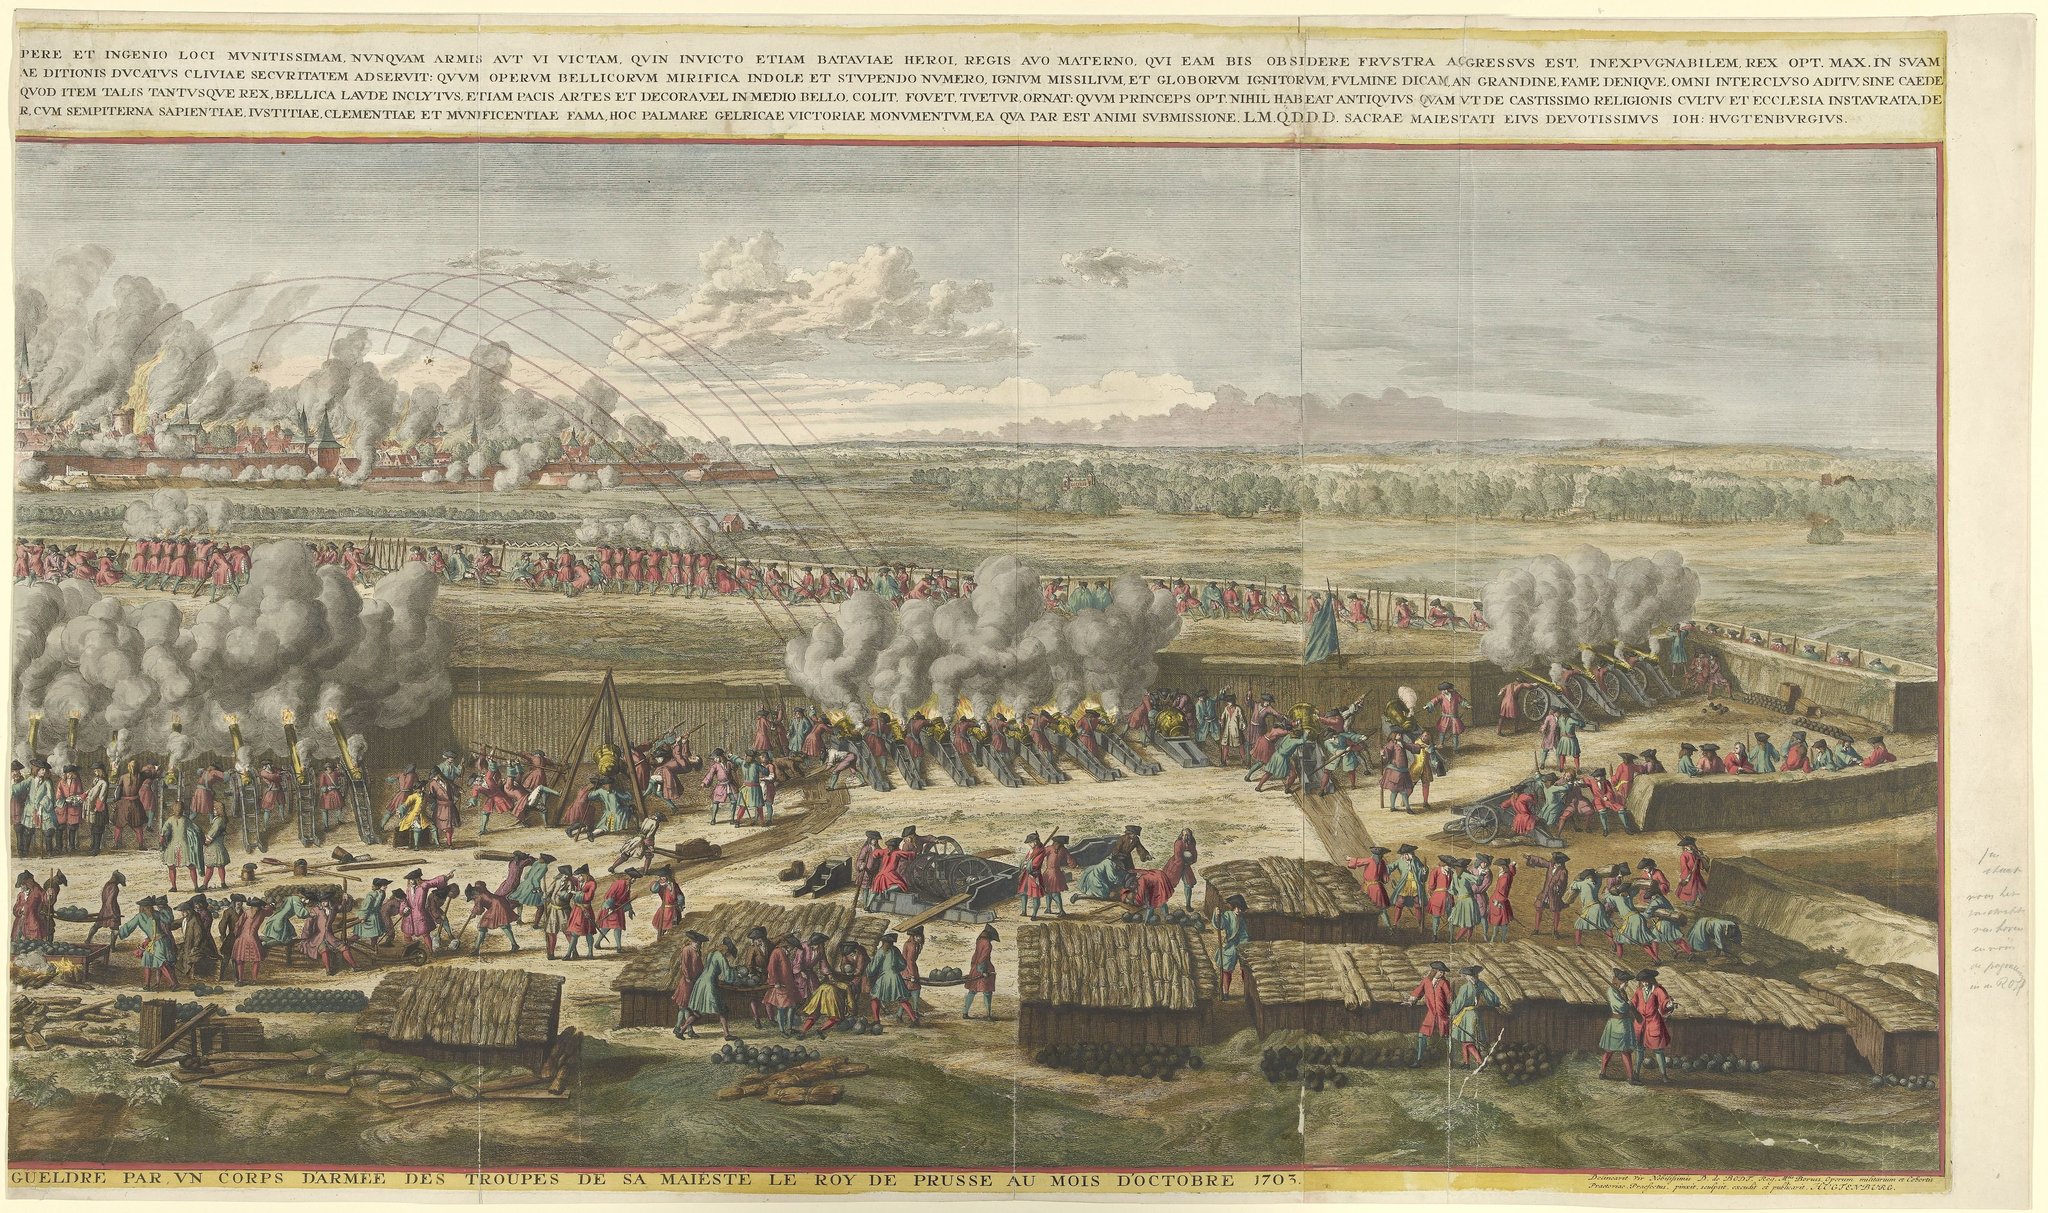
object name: print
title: Veue perspective du bombardement de la ville de Gueldre par un corps d'armée des troupes de sa maieste le roy de Prusse au mois d'octobre 1703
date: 1703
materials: paper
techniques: engraving, etching, hand coloring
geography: northern netherlands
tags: siege, position war, projectiles, explosives, etc., bombardment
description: Middel en rechter plaat van een grote prent van het bombardement van Geldern door de Pruisische troepen onder generaal Lotthum in de maand oktober 1703. Zeer brede voorstelling (gedrukt van drie platen) vanuit het kamp van de belegeraars waar kanonskogels worden gefabriceerd en afgeschoten. Staat vóór het nummer en de Nederlandse titel. Aan de bovenzijde is een strook geplakt met gegraveerde tekst in het Latijn waarin de opdracht staat. Zie RP-P-OB-83.394A voor het andere deel van de prent.